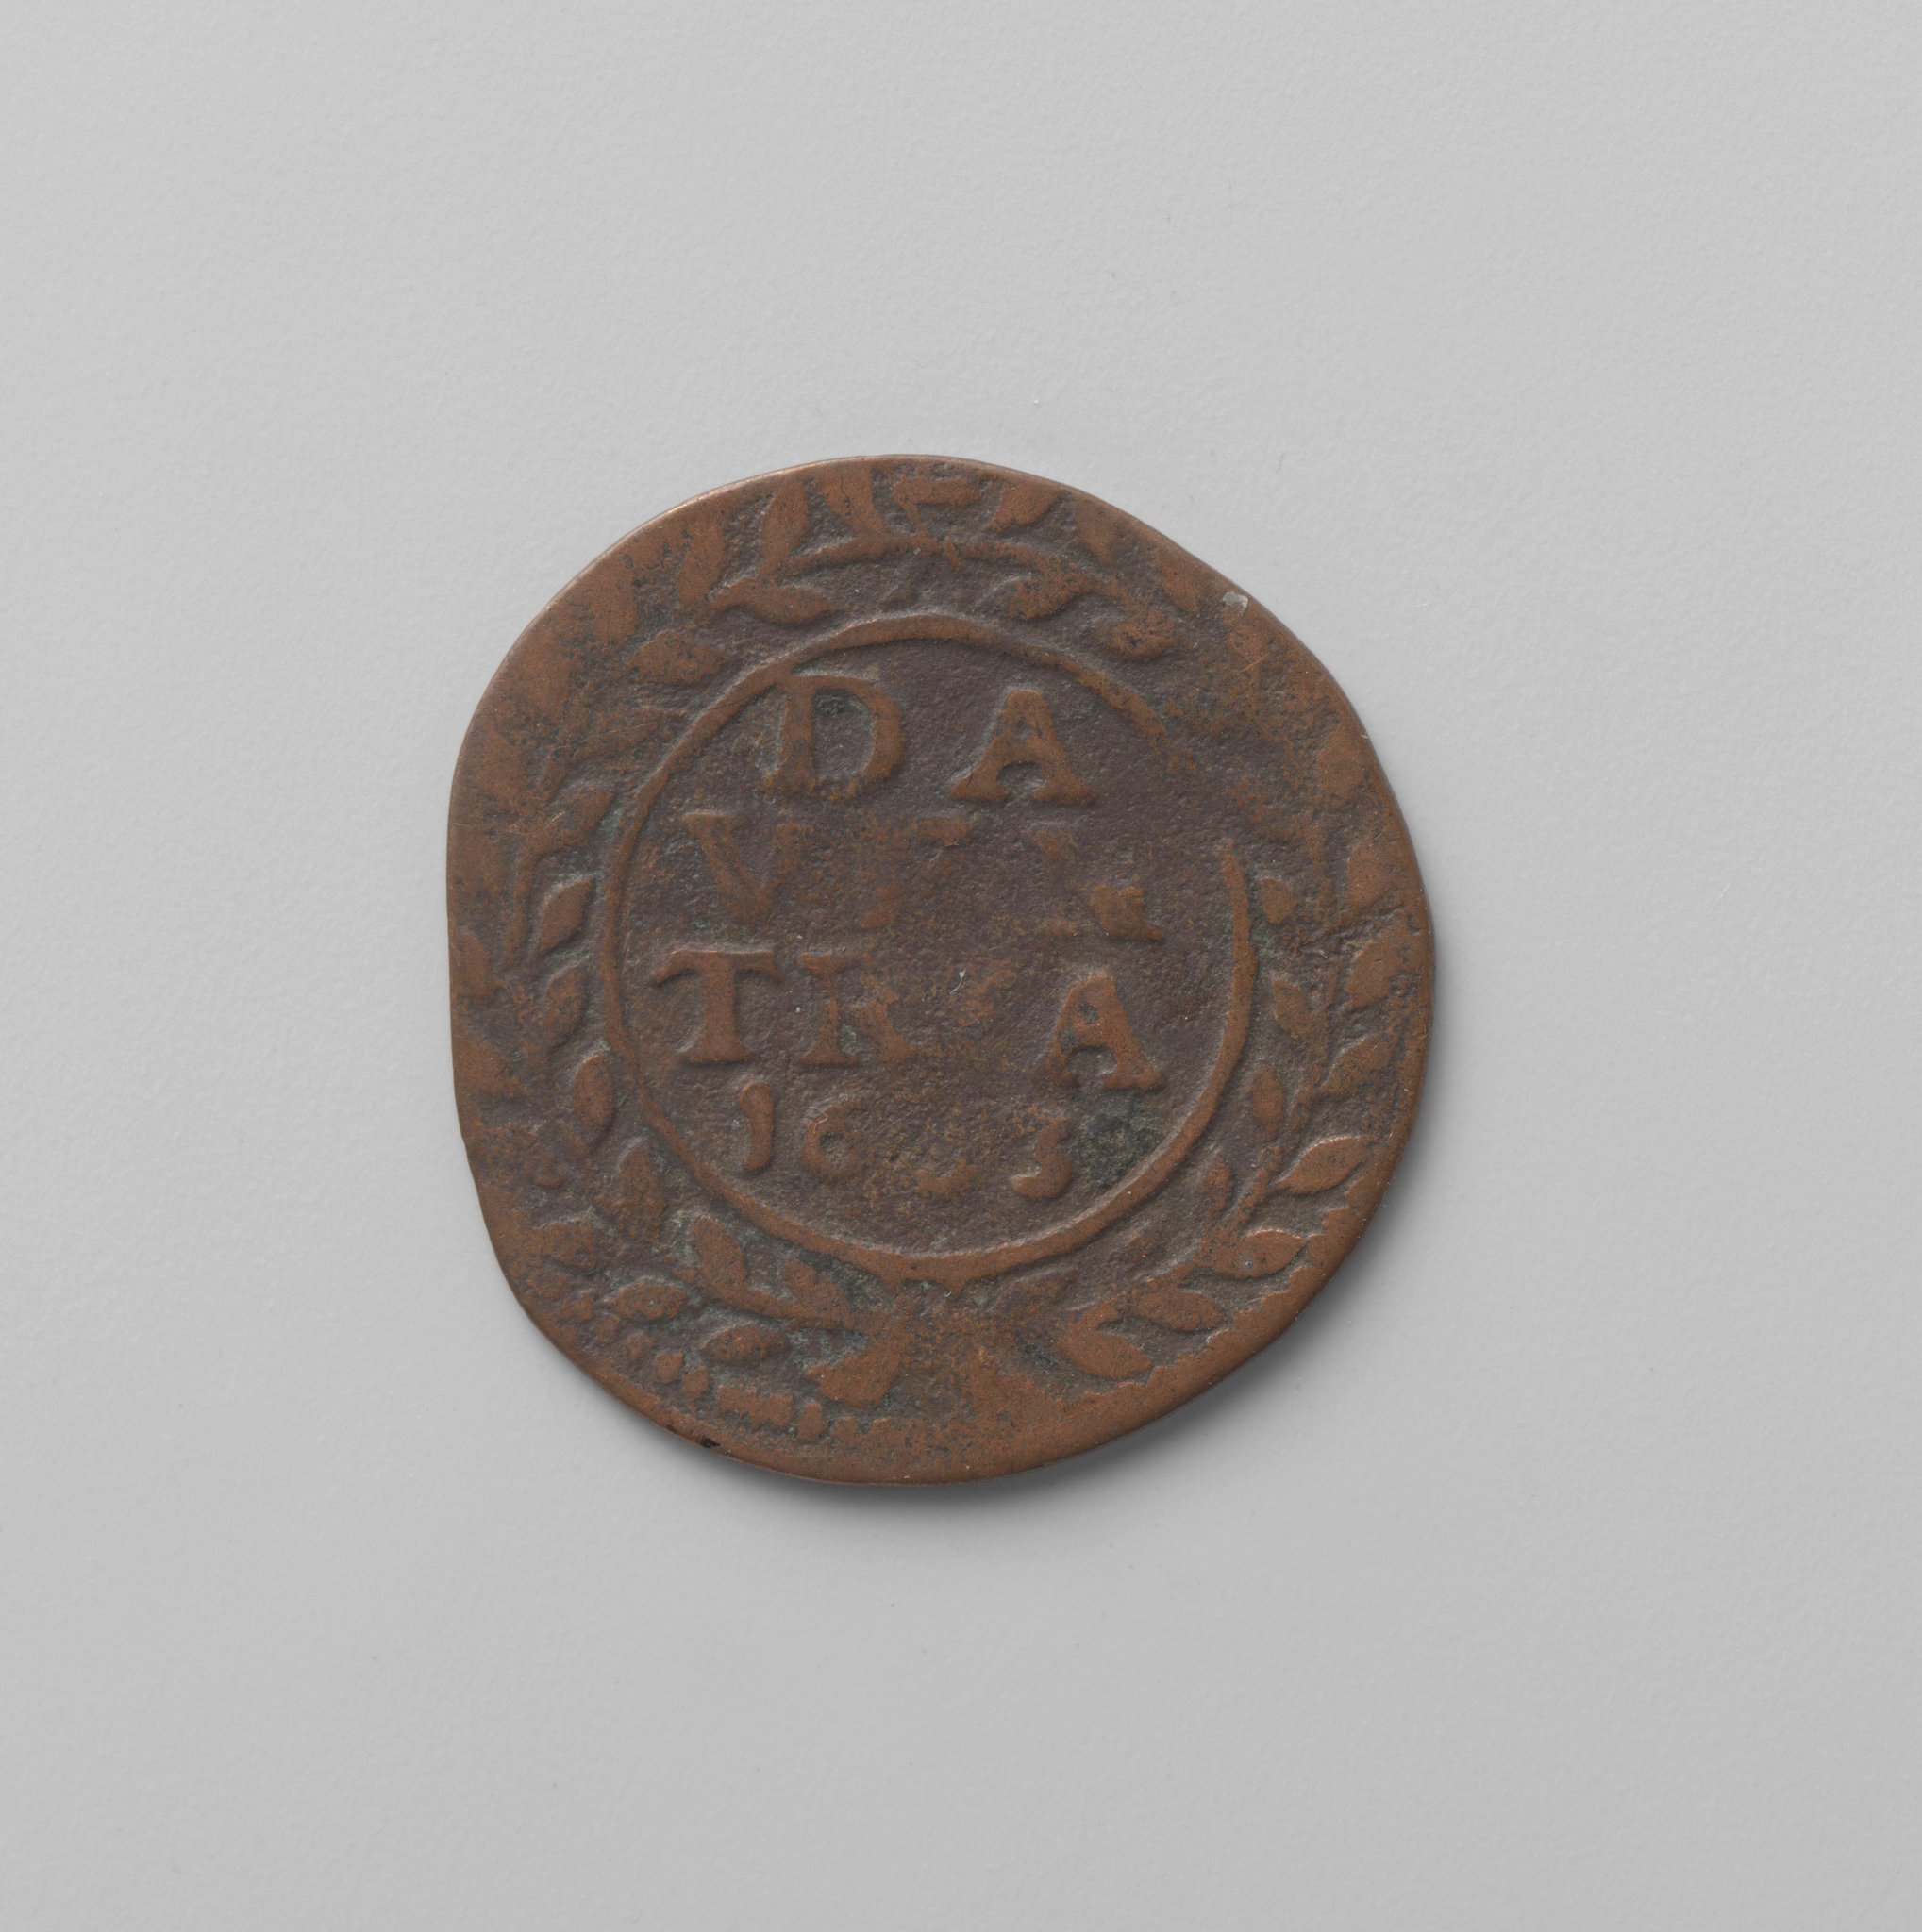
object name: coin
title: Deventer, duit, 1663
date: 1663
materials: copper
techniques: striking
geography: deventer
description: Koperen munt. Voorzijde: tussen een bladerkrans gekroond wapenschild van Deventer. Keerzijde: binnen een bladerkrans drieregelig opschrift, waaronder jaartal.